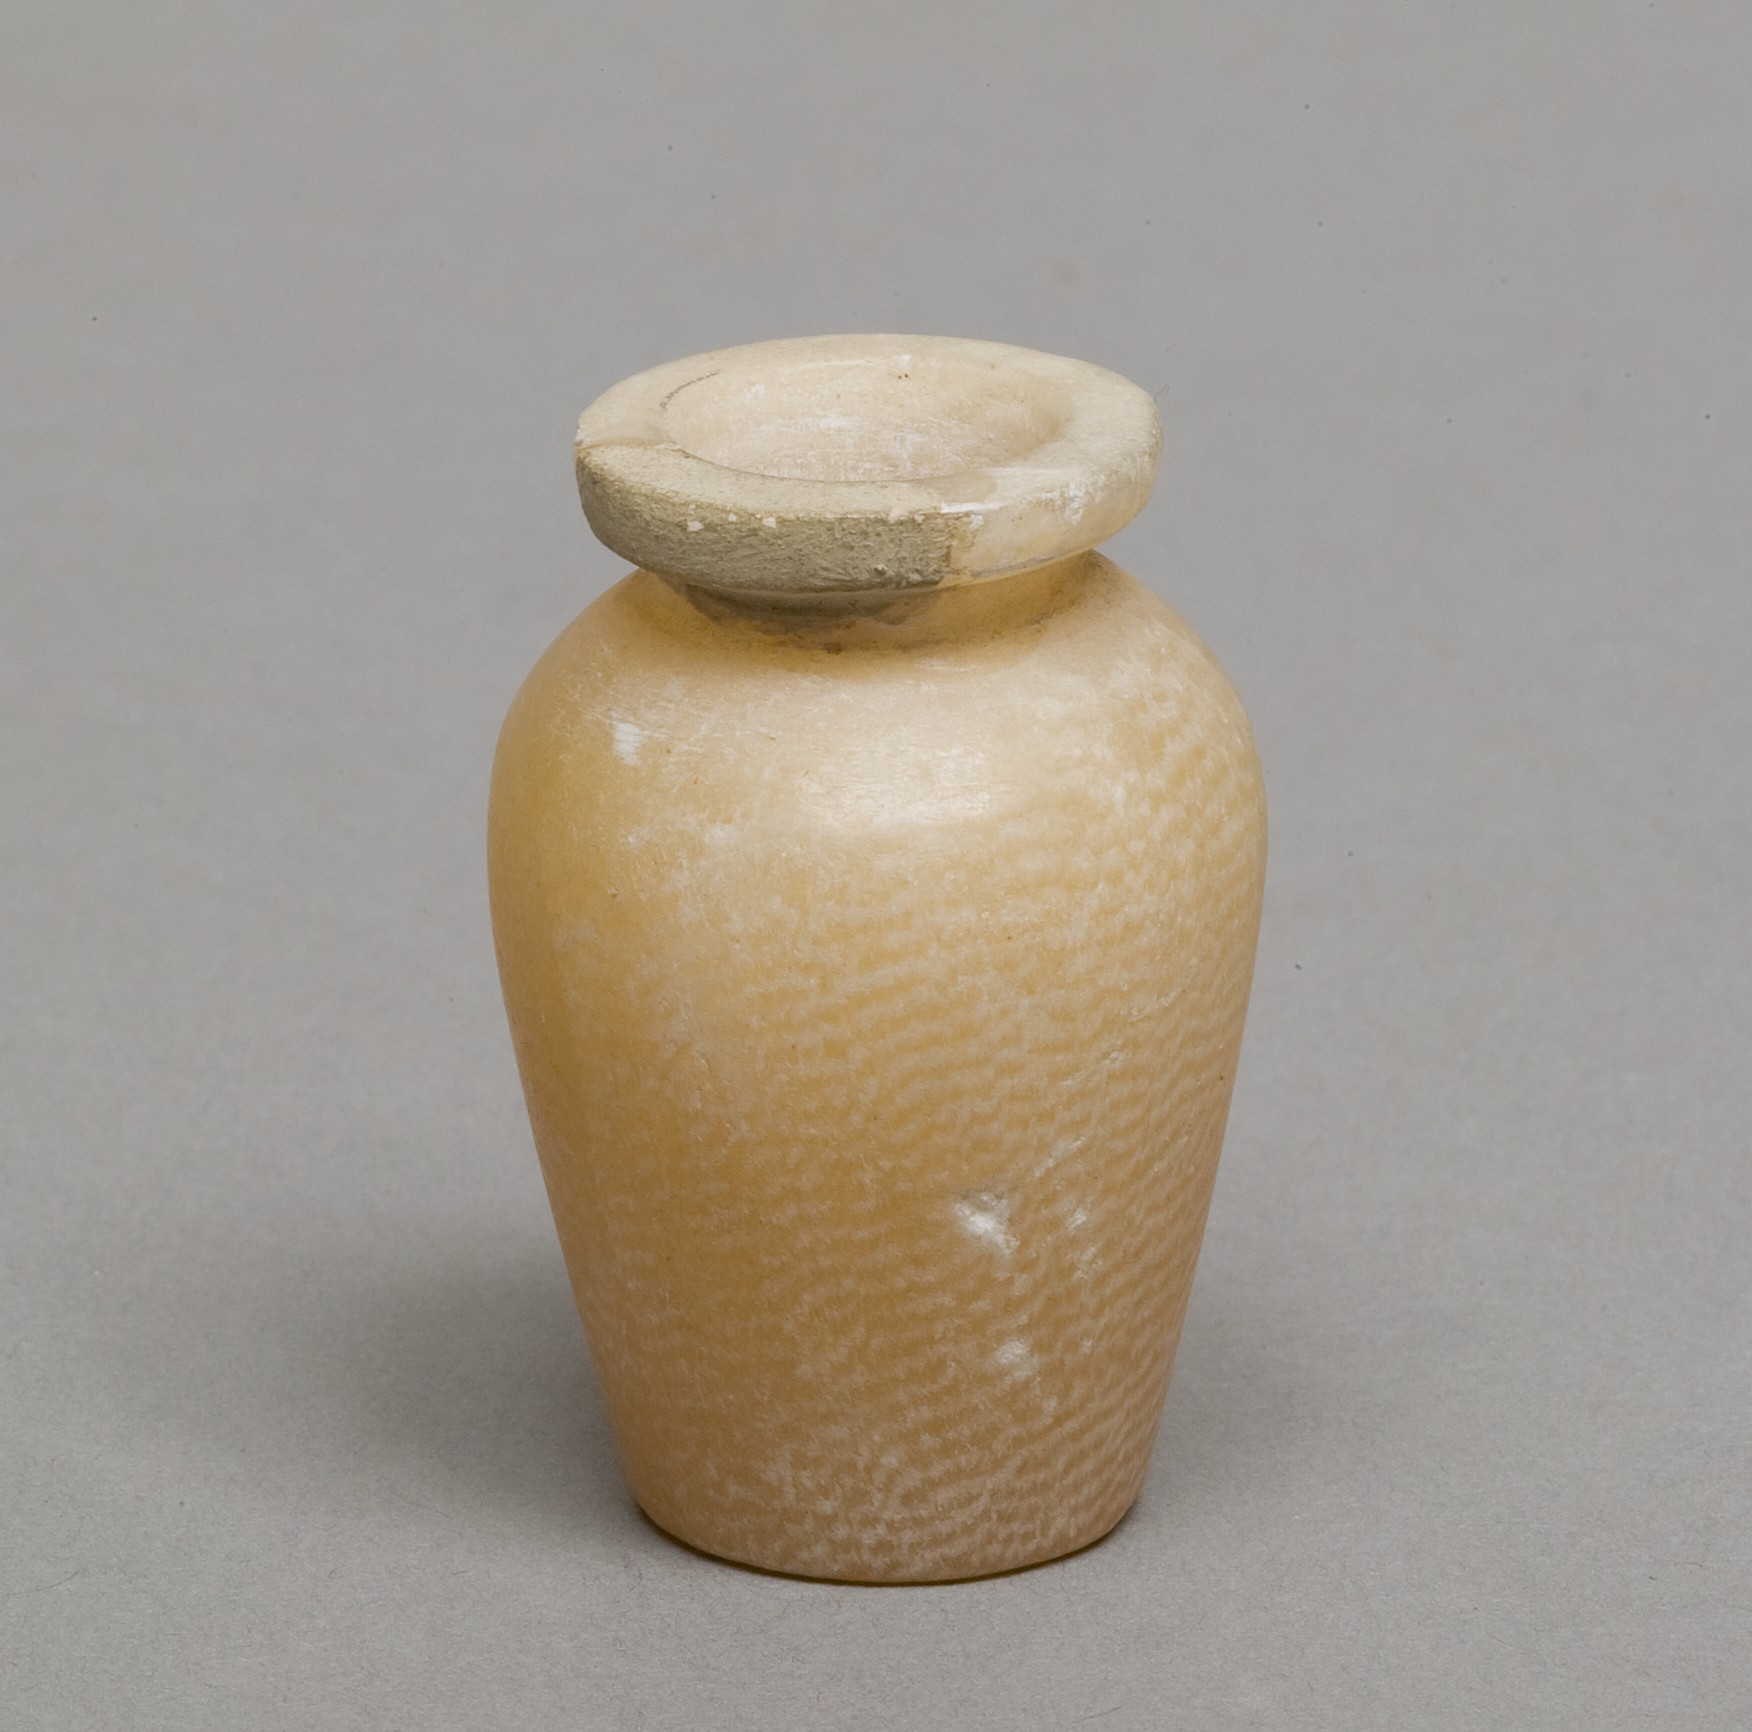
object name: toilet jar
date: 1900-1800 BCE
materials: stone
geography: egypt